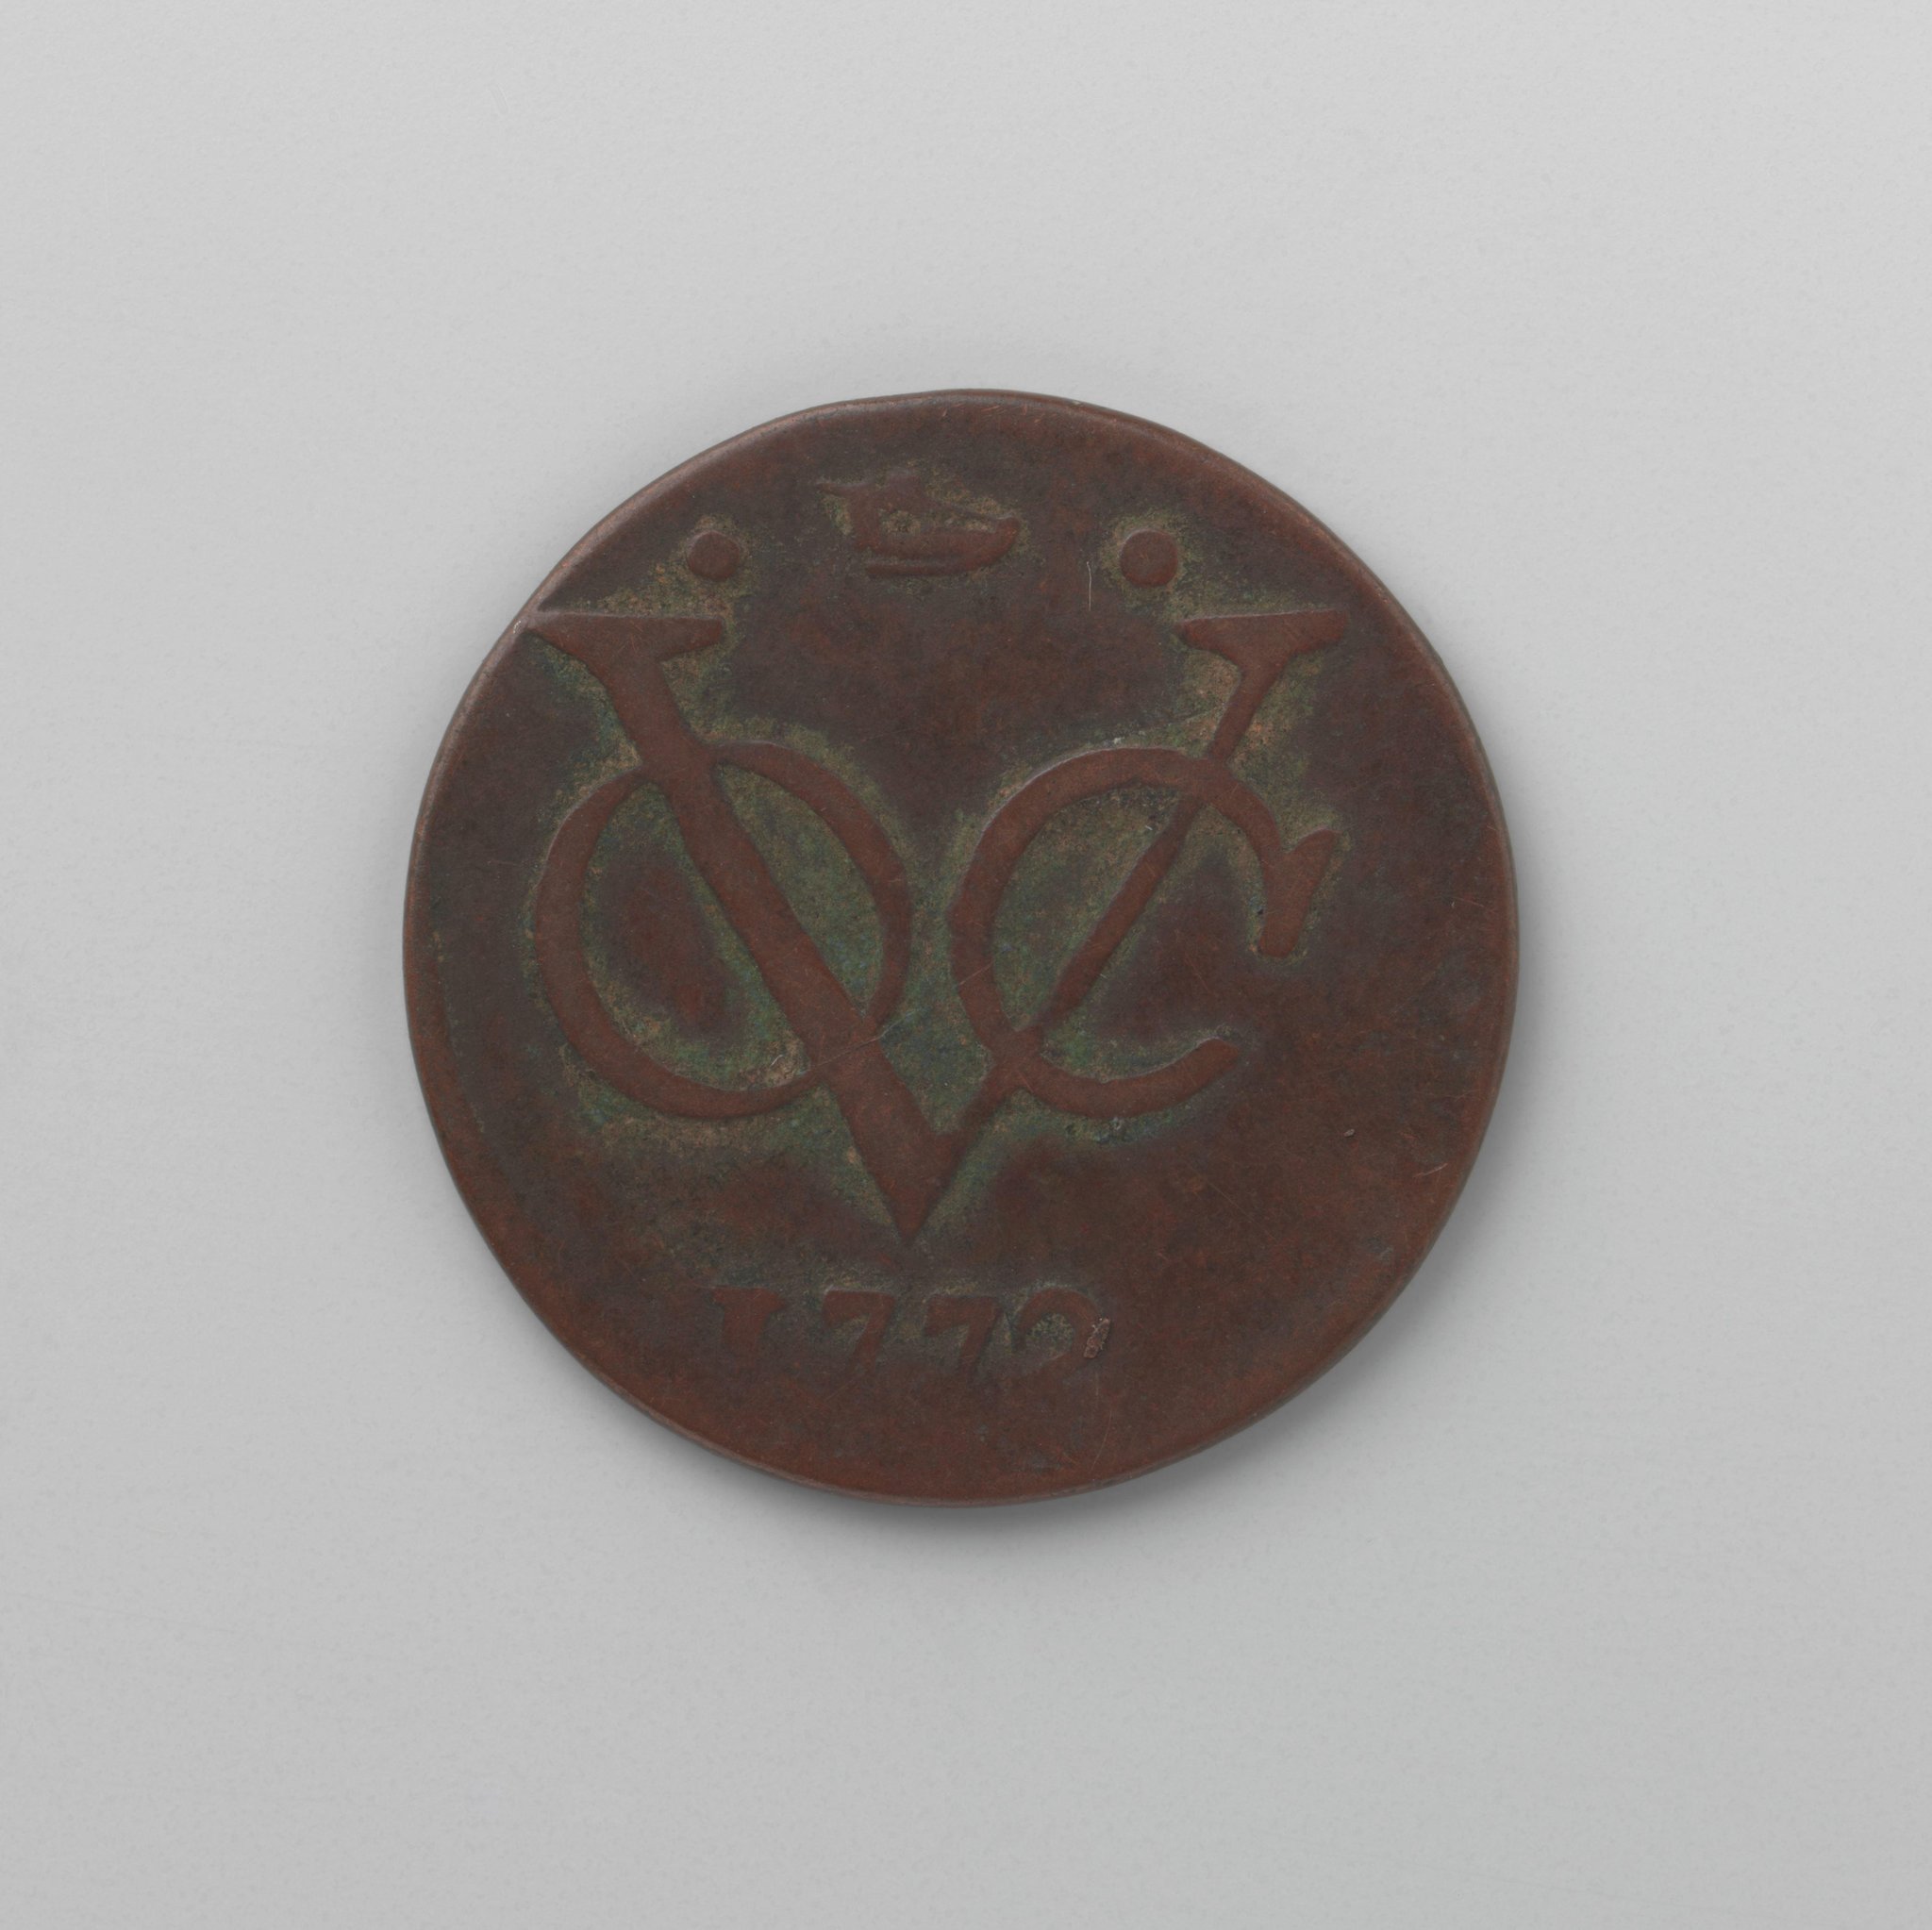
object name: coin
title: Duit van de VOC uit Westfriesland,1772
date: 1772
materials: copper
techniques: striking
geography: medemblik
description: Koperen munt. Voorzijde: gekroond wapenschild van Westfriesland. Keerzijde: monogram van de VOC, waarboven muntmeesterteken en waaronder jaartal. Gladde rand.